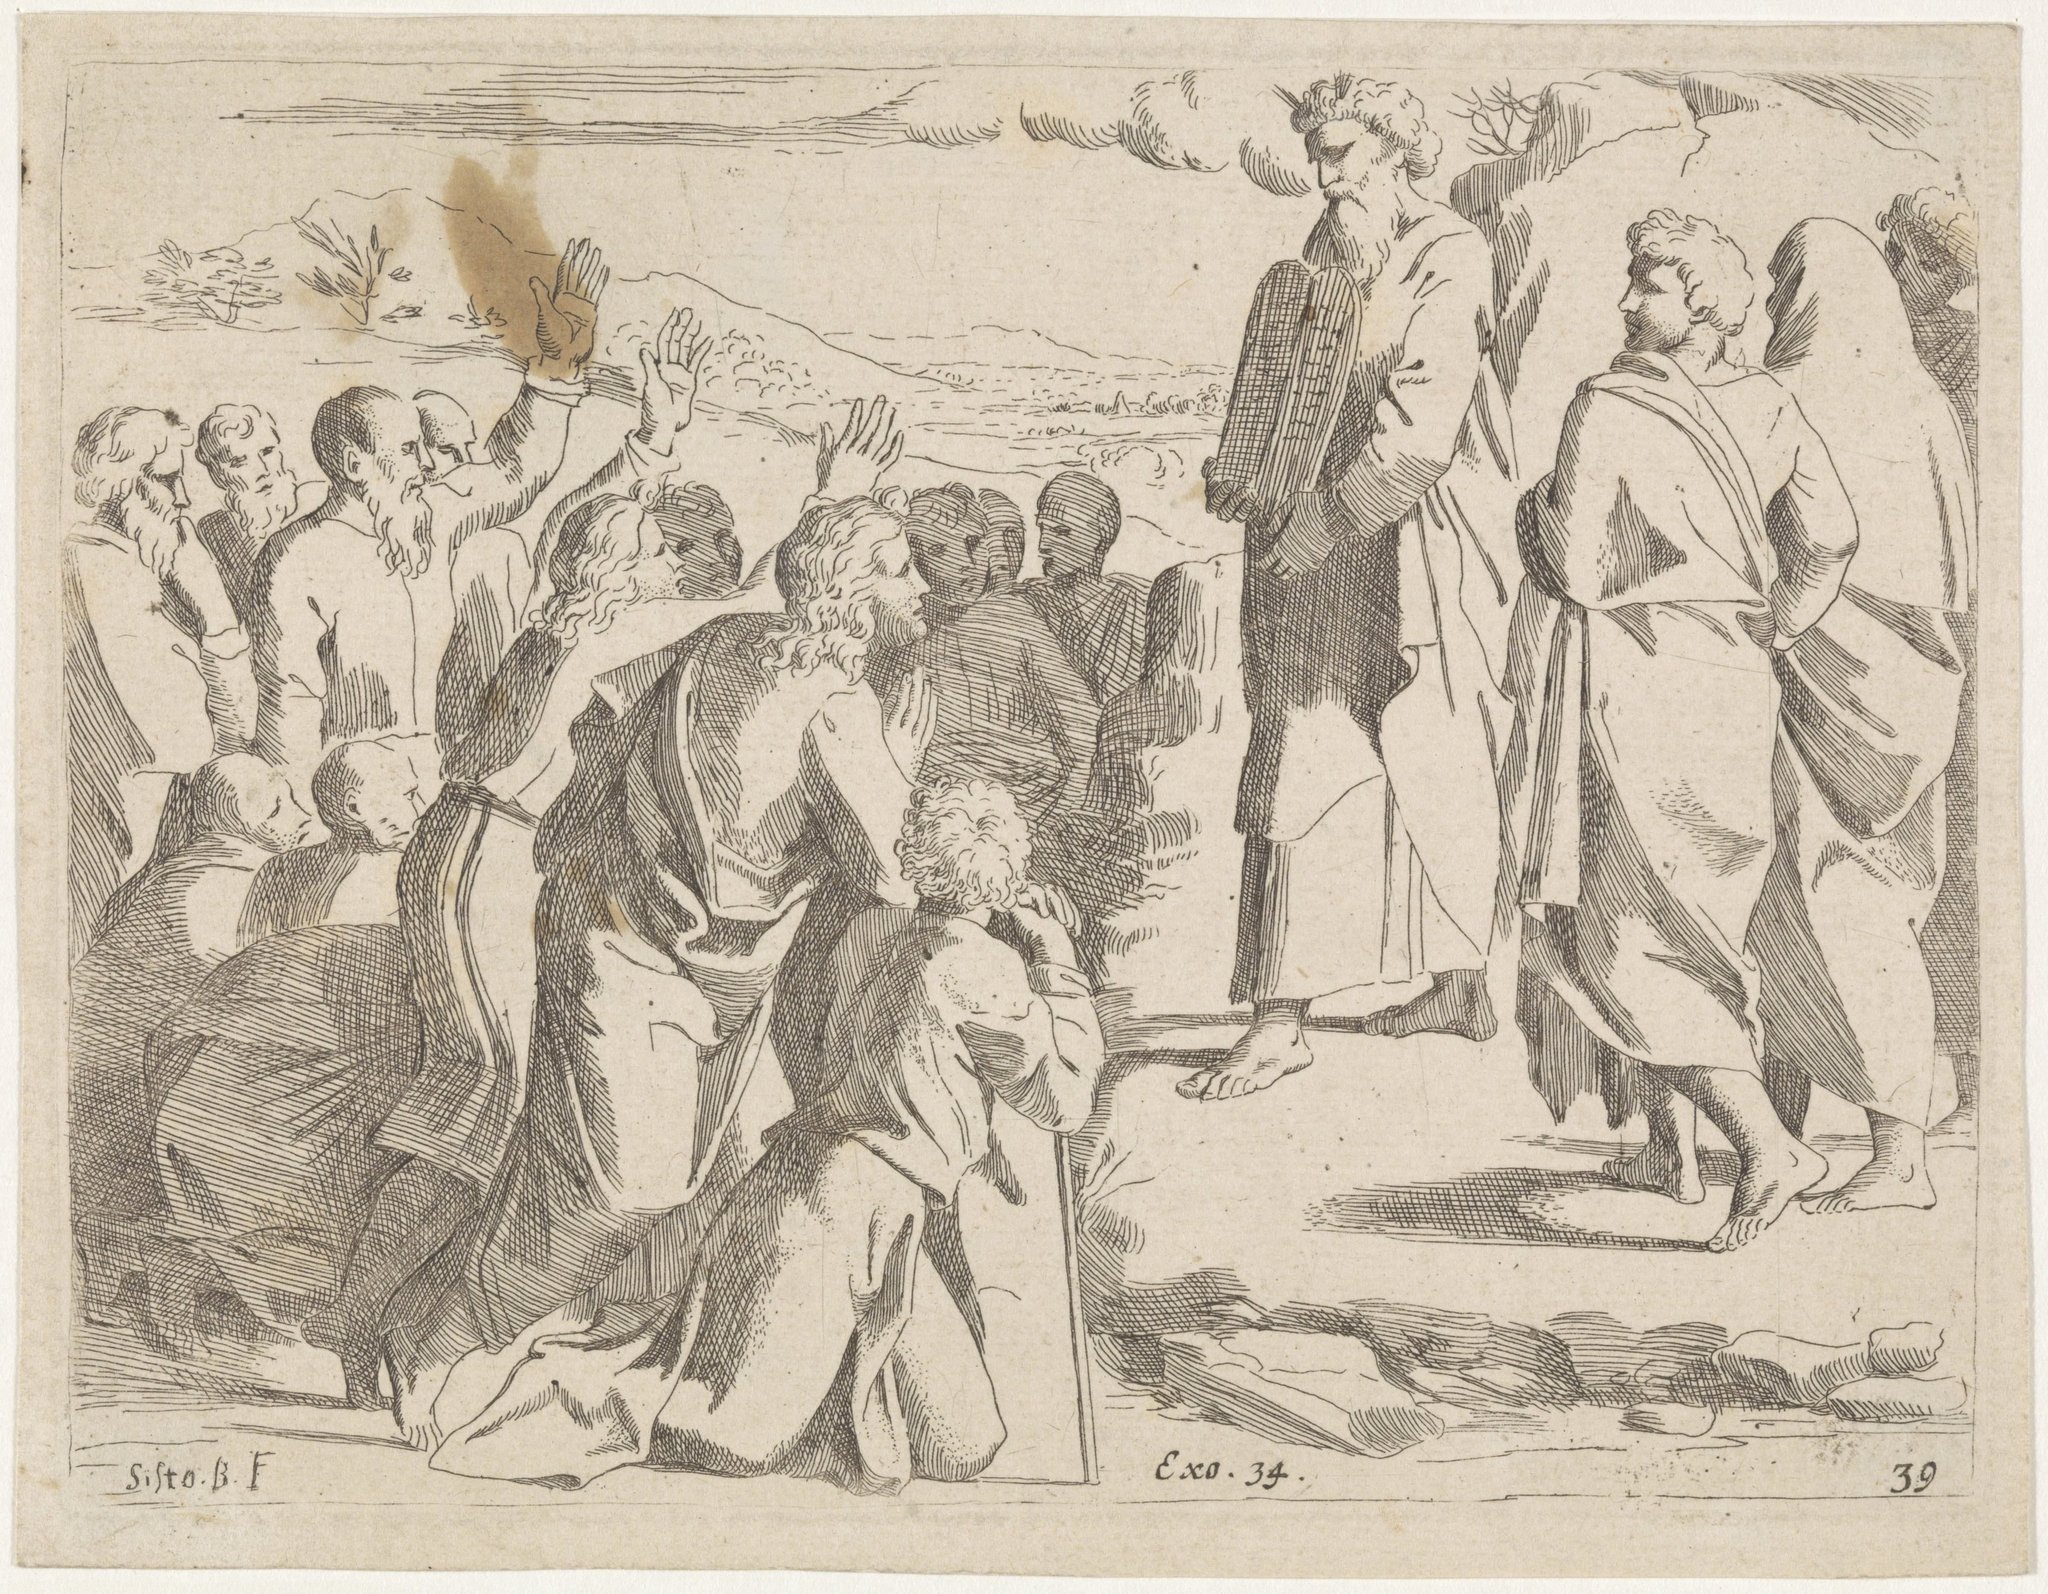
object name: print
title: Bijbelse scènes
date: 1607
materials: paper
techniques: etching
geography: vatican city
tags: the ten commandments (exodus 20:3-17)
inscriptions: collector's mark: Lugt 2228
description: Mozes staat op een verhoging en toont de tafelen der wet aan het volk. Midden onder de verwijzing: Exo. 34. Genummerd rechtsonder: 39.